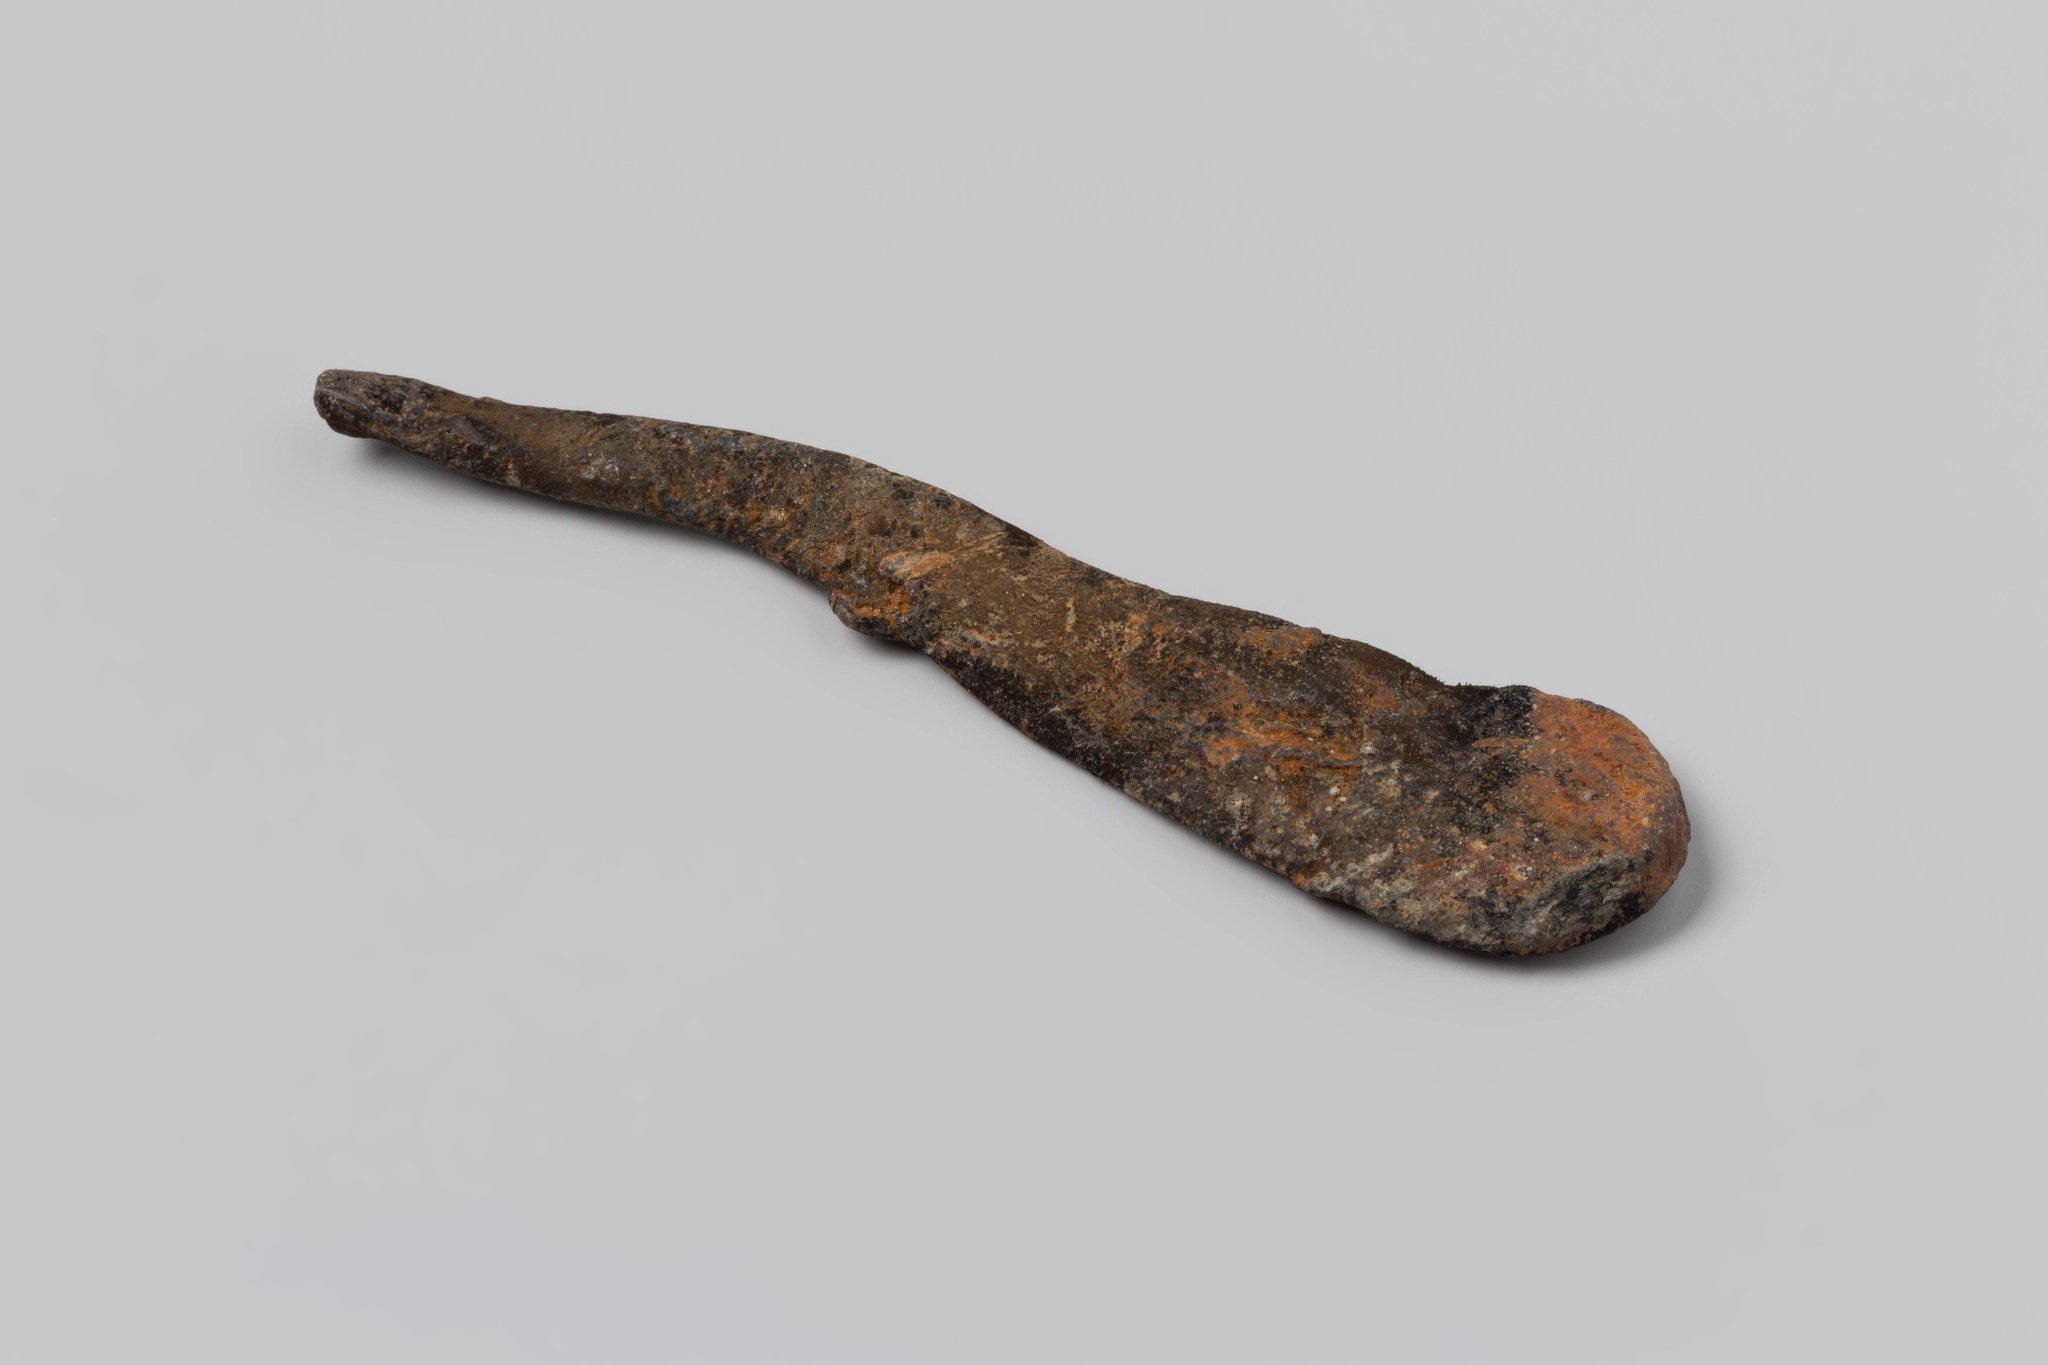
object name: spoon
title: Steel van vork of lepel uit het wrak van de Oost-Indiëvaarder Hollandia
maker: Anonymous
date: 1700-1743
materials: tin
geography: netherlands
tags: verenigde oostindische compagnie, hollandia (schip), annet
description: Cutlery, fragment: stem of fork or spoon; fragm, id. NG 1980-27H67.